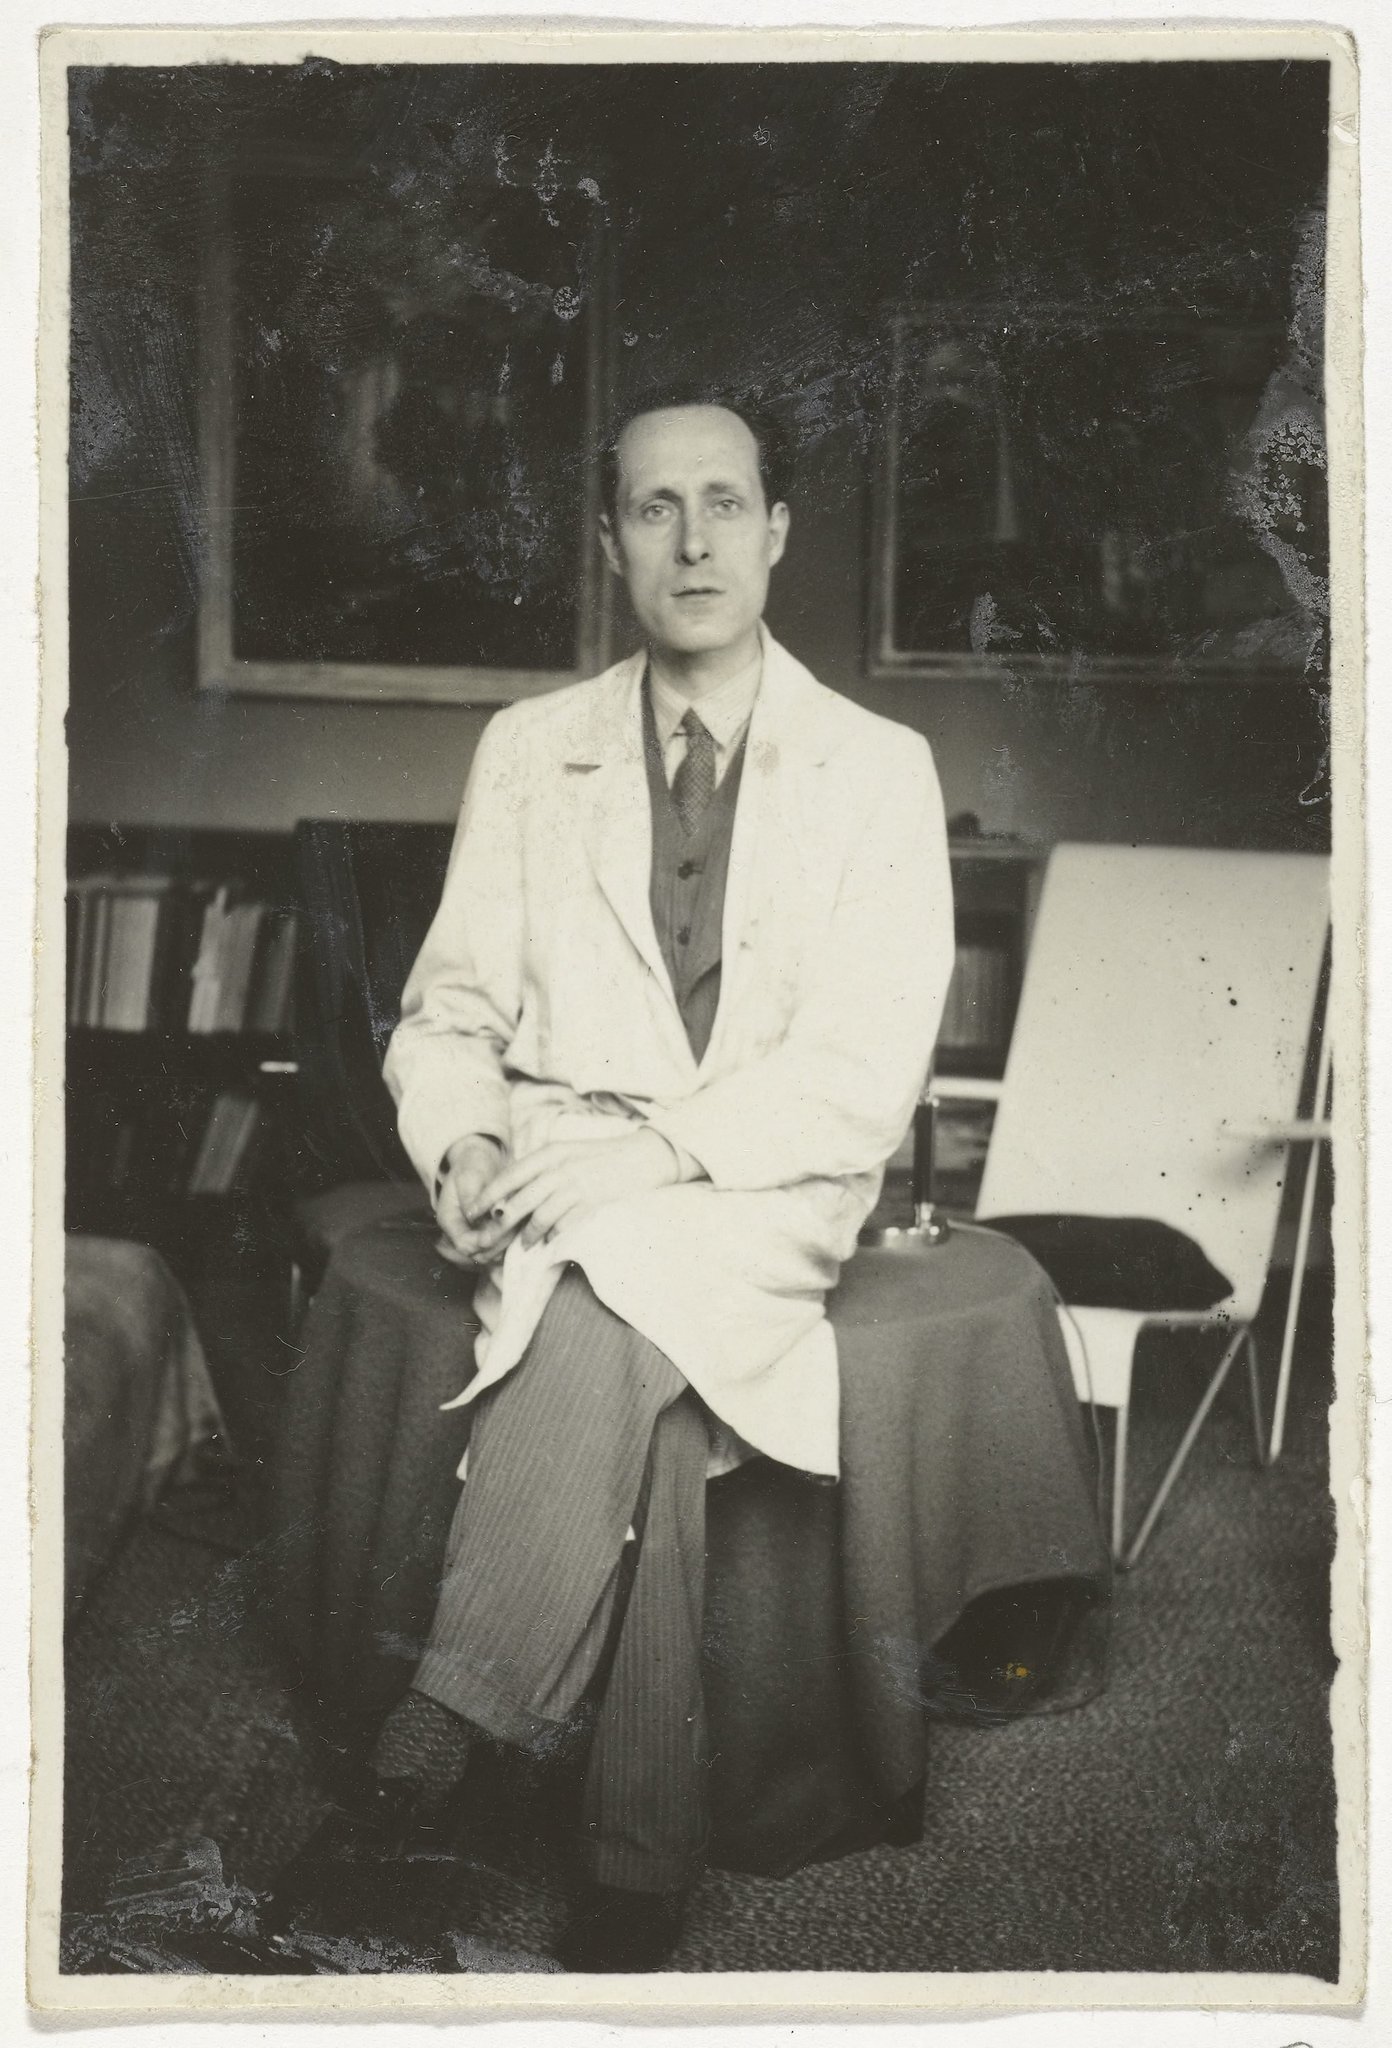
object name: photograph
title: Portret van Carel Willink in lange witte jas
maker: Anonymous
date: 1930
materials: paper, photographic support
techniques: gelatin silver print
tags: amsterdam, print maker, draughtsman, carel willink, historical persons (portraits and scenes from the life)